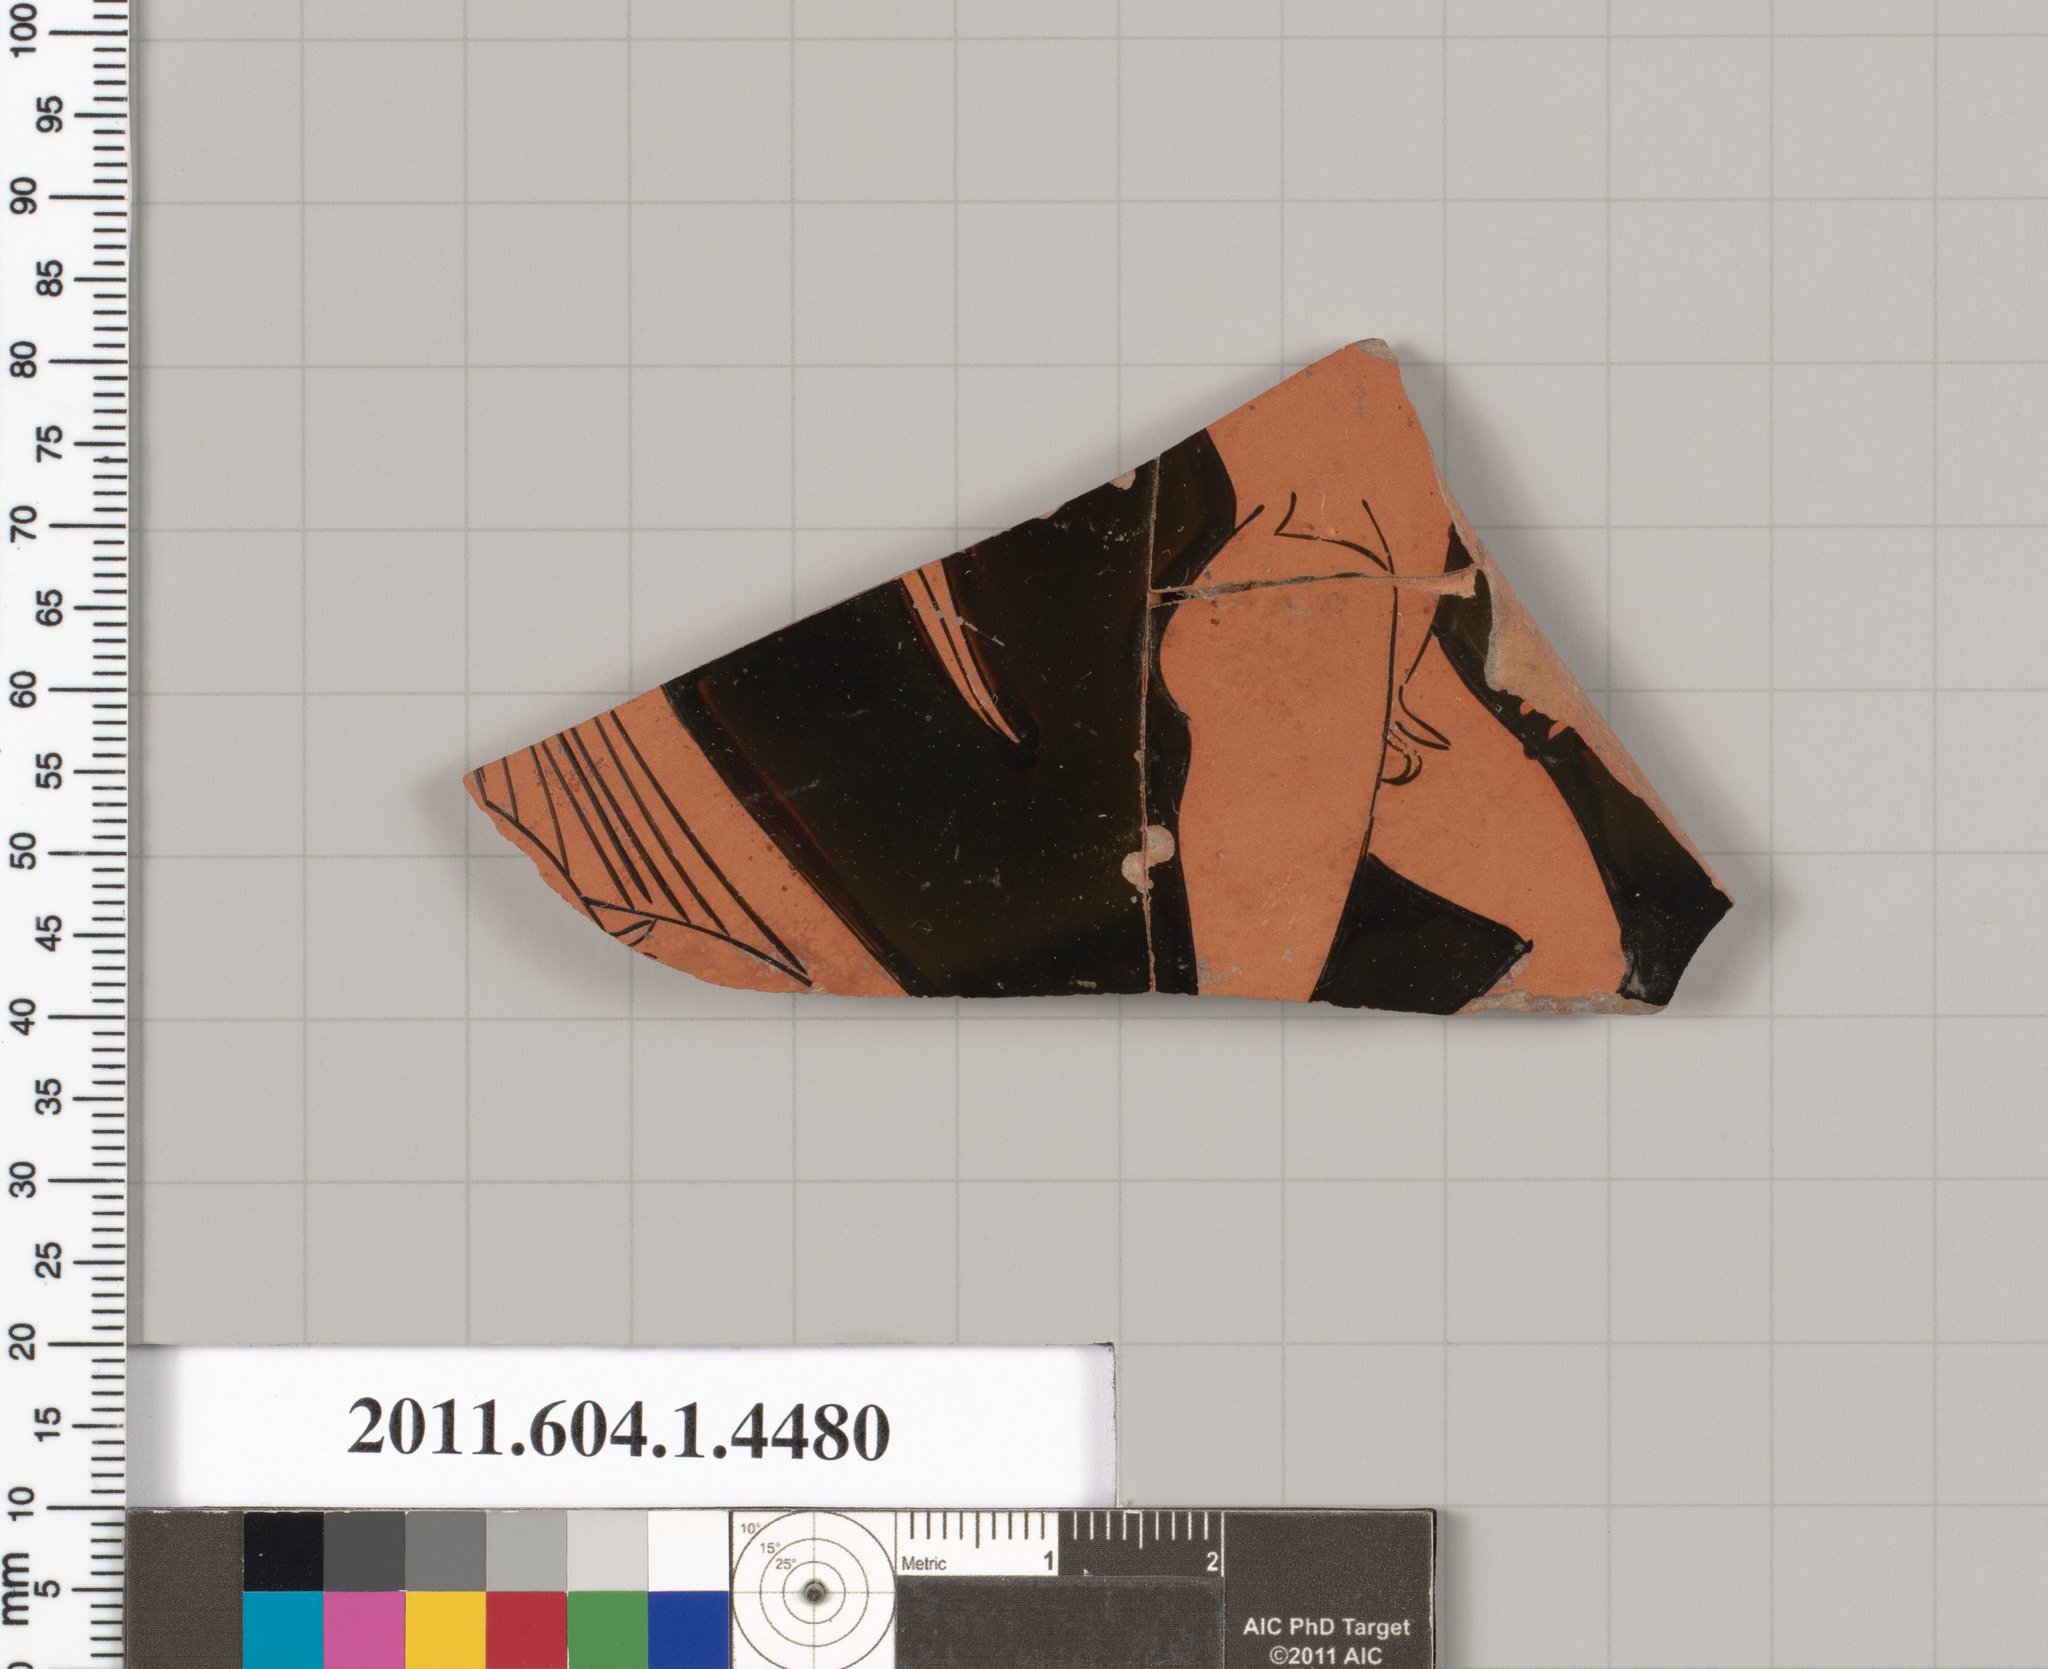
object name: kylix fragment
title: Terracotta fragment of a kylix (drinking cup)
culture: greek, attic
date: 480-470 BCE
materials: terracotta